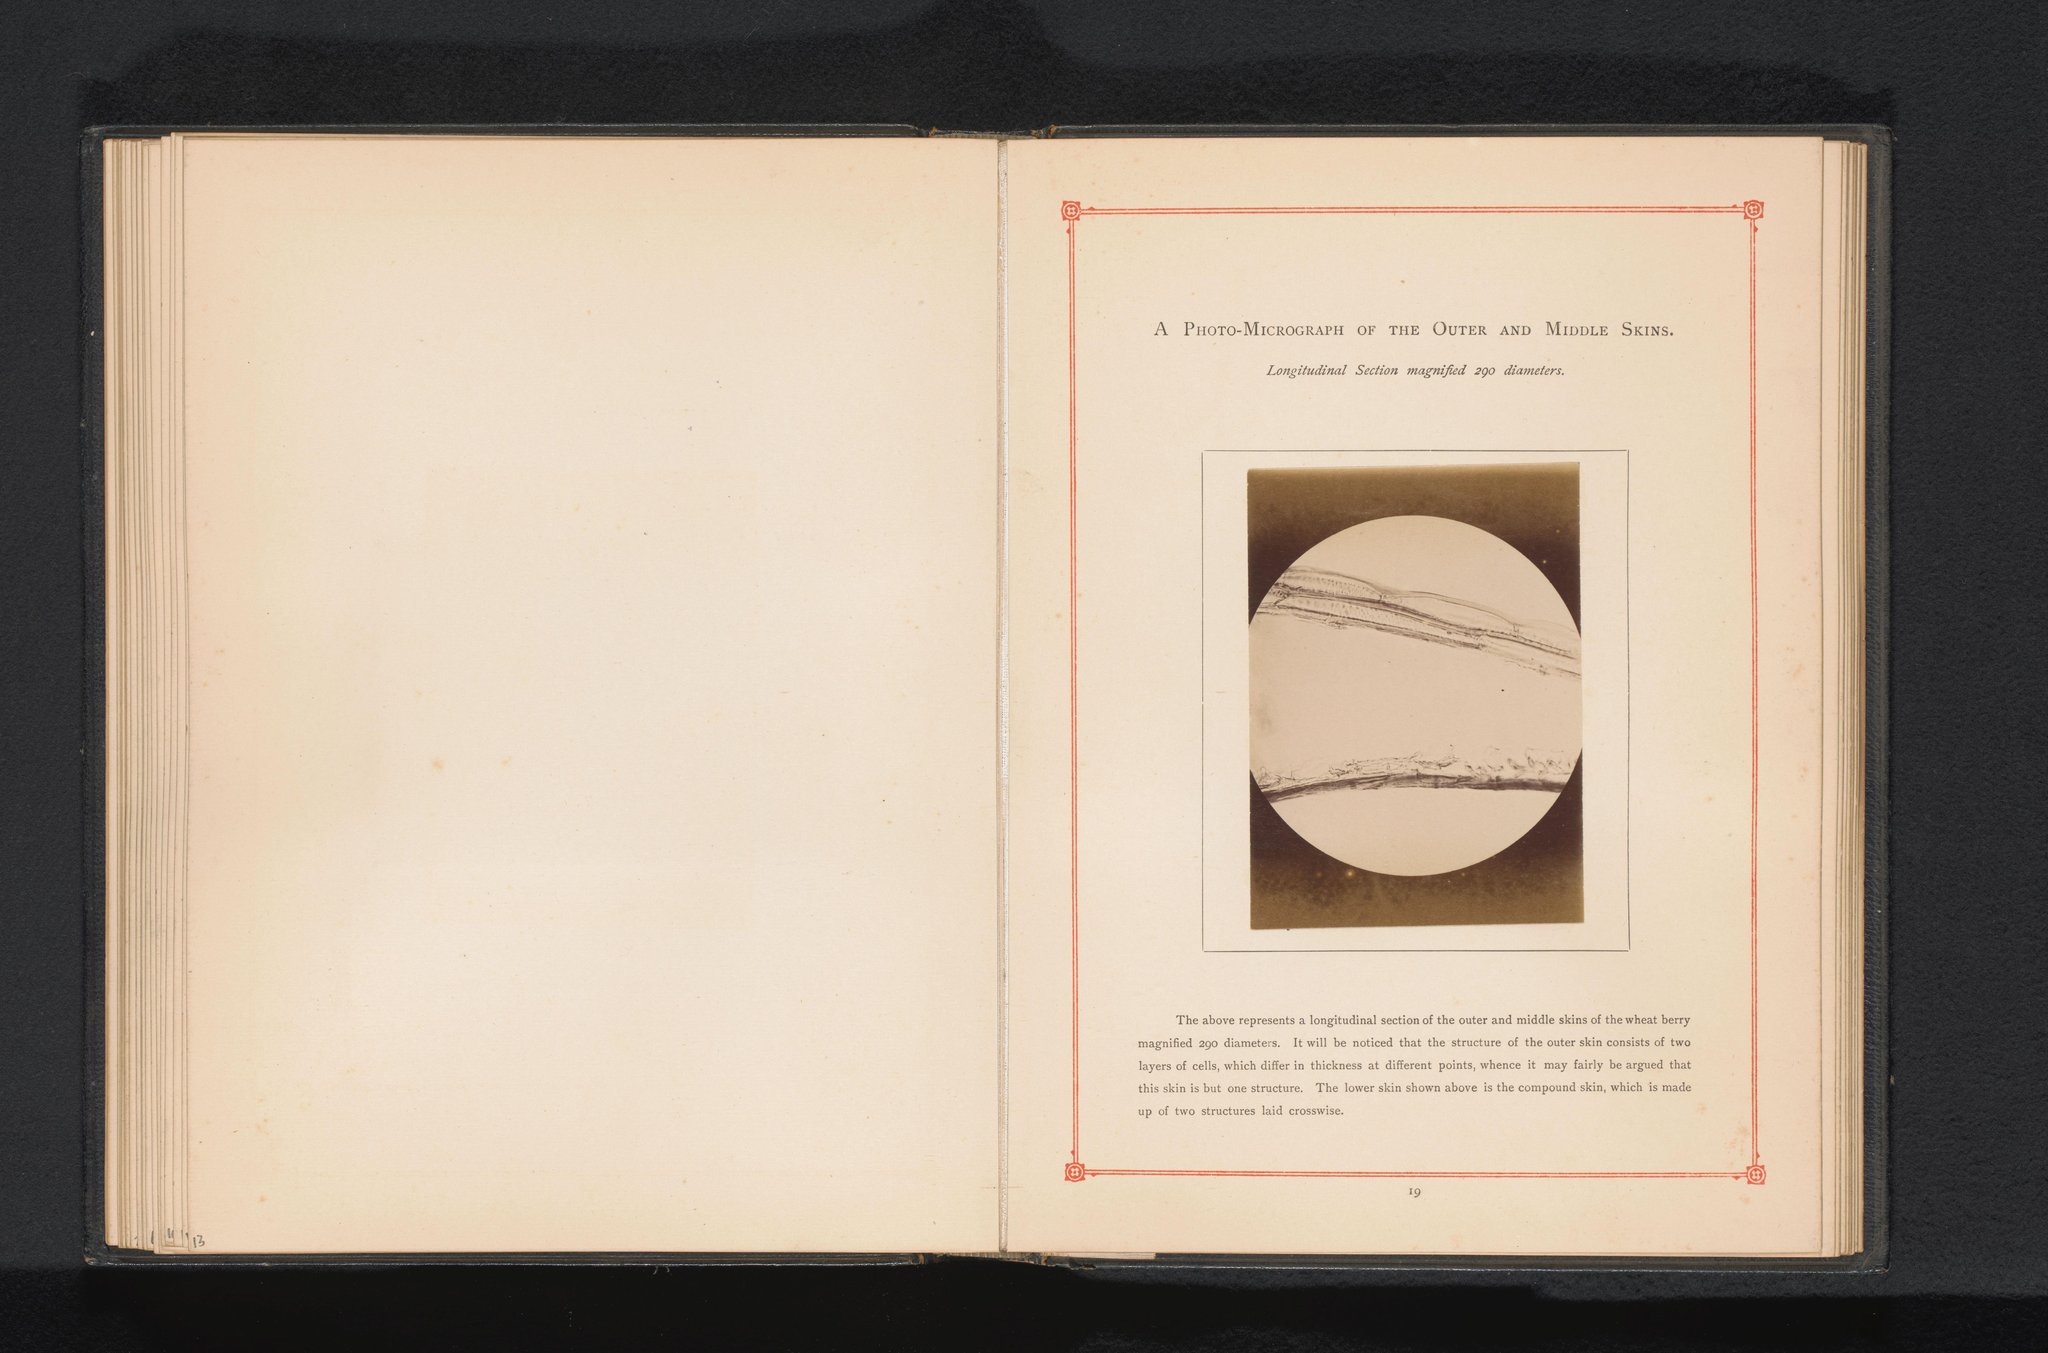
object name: photograph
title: Microscoopopname van een lengtedoorsnede van een tarweplant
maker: robert w. dunham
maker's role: fotograaf, wetenschapper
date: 1882-1892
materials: photographic support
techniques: albumen print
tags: plants and herbs: wheat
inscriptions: inscription: ‘Longitudinal section magnified 290 diameters.’